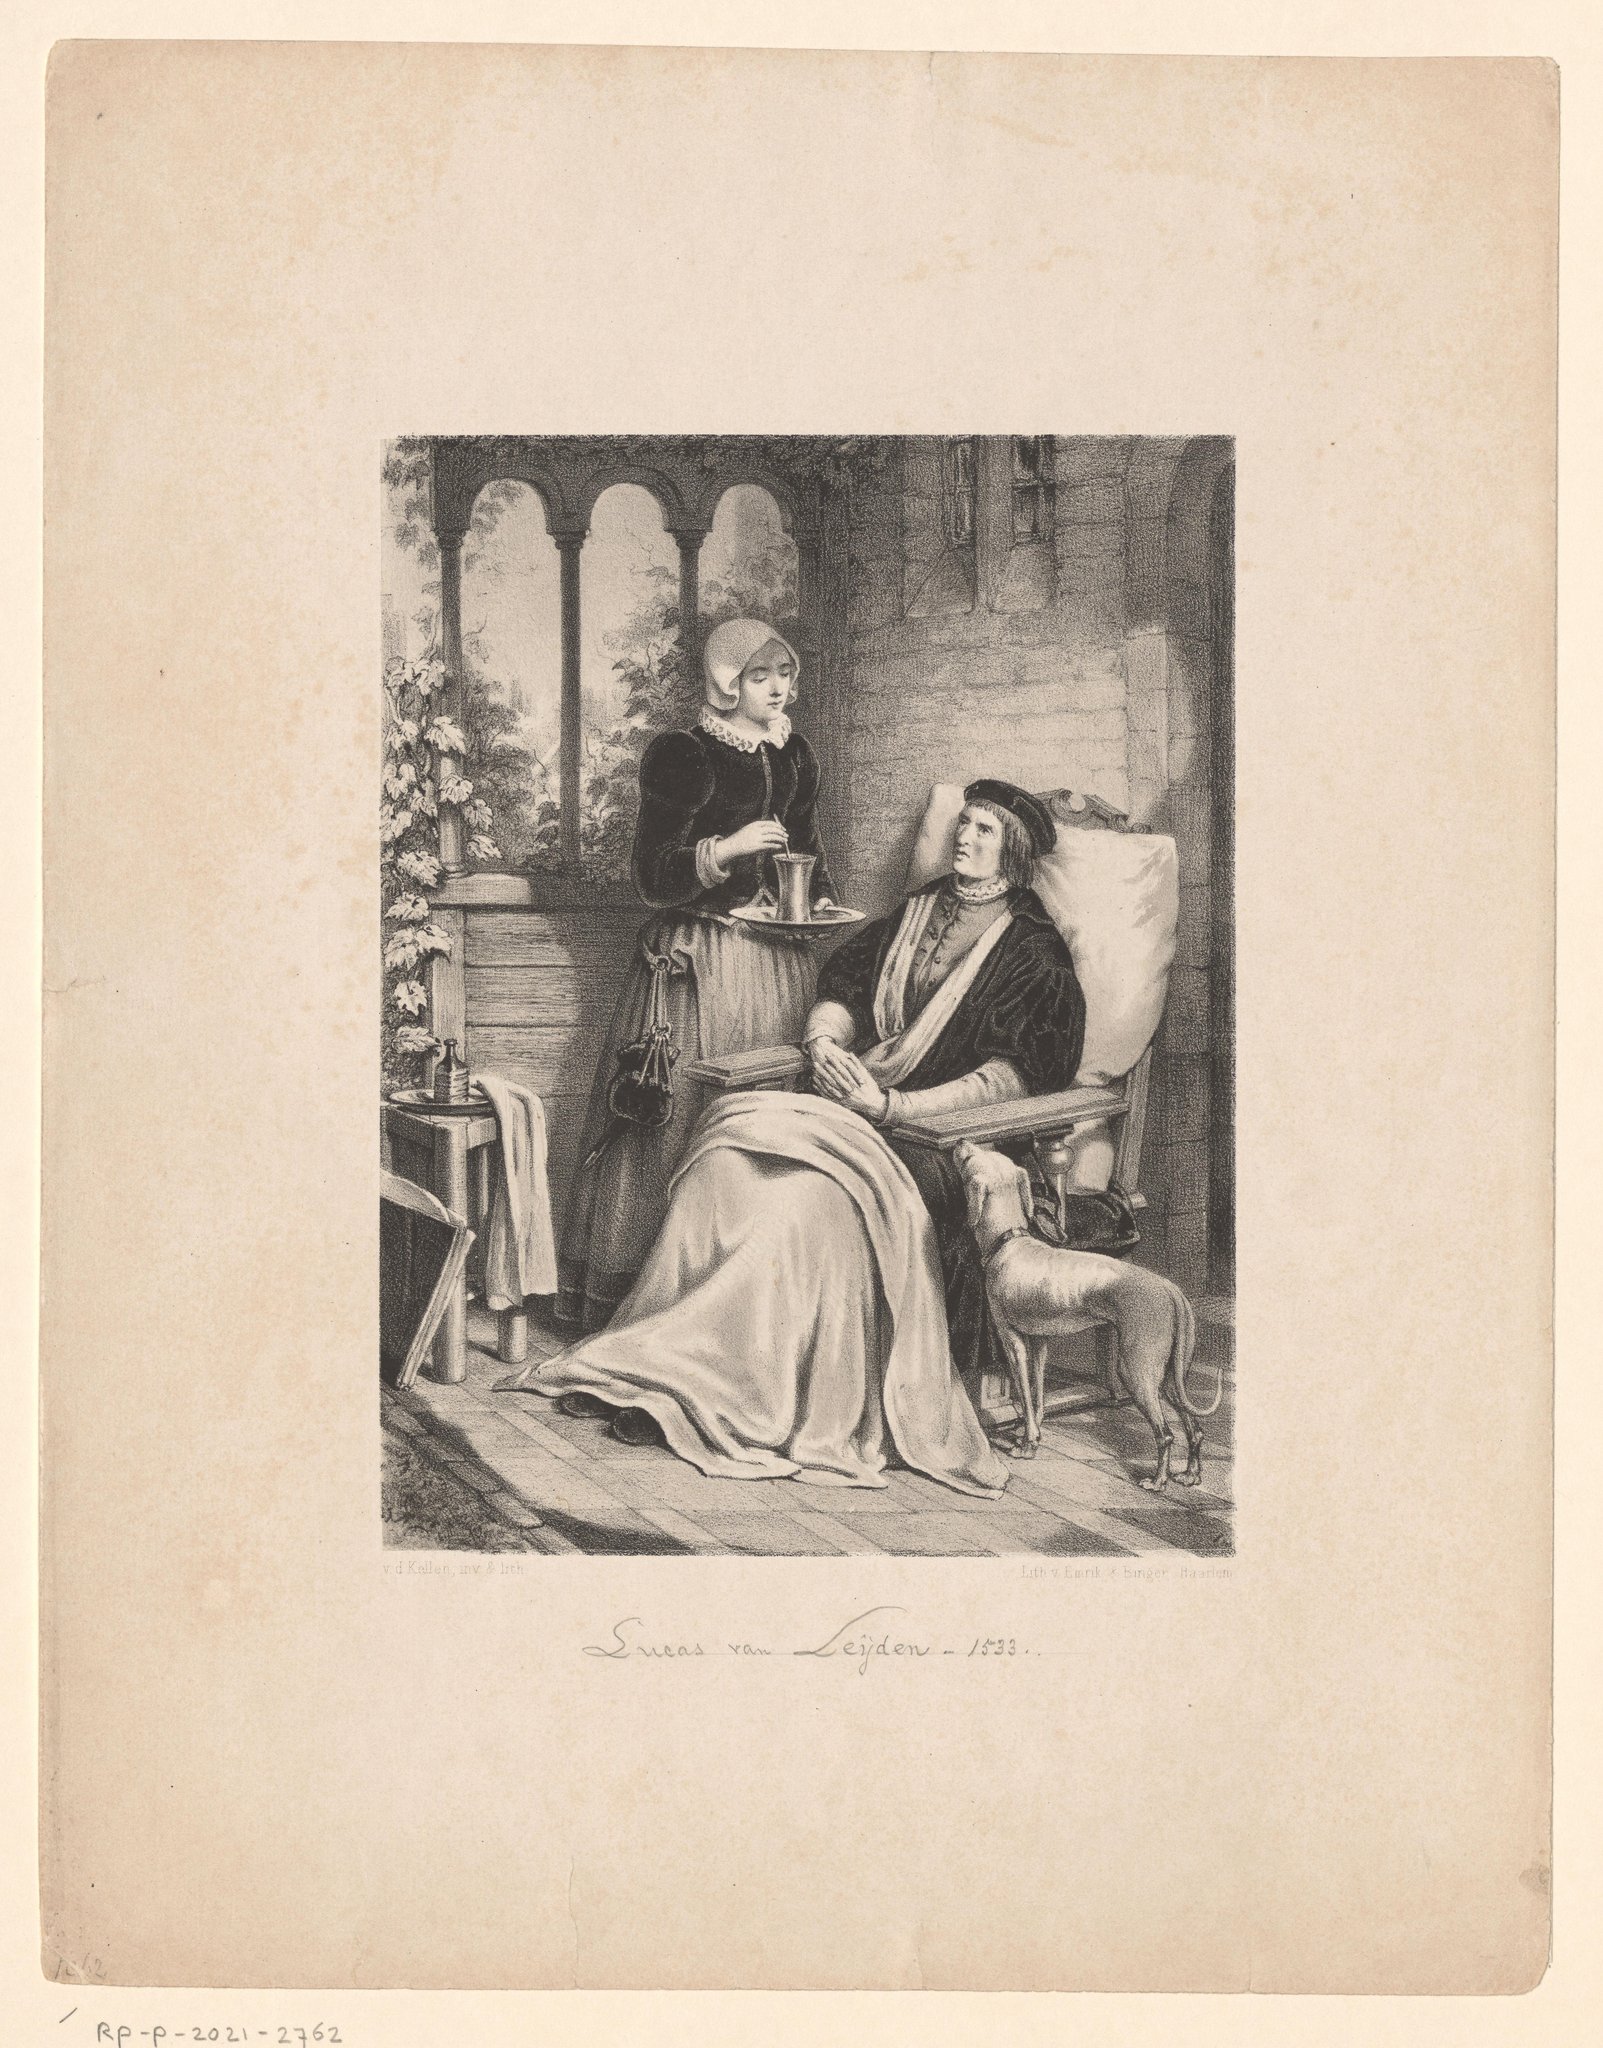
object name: print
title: Dood van Lucas van Leyden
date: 1863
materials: paper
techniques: lithograph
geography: leiden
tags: leiden, painter, print maker, draughtsman, lucas van leyden, death by disease, historical persons, nursing, tending the sick, dog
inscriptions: inscription: ‘Lucas van Leijden 1533’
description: De kunstenaar Lucas van Leyden zit in een stoel met een deken over zijn benen. Naast hem staat een vrouw met een beker. Rechts staat zijn hond.